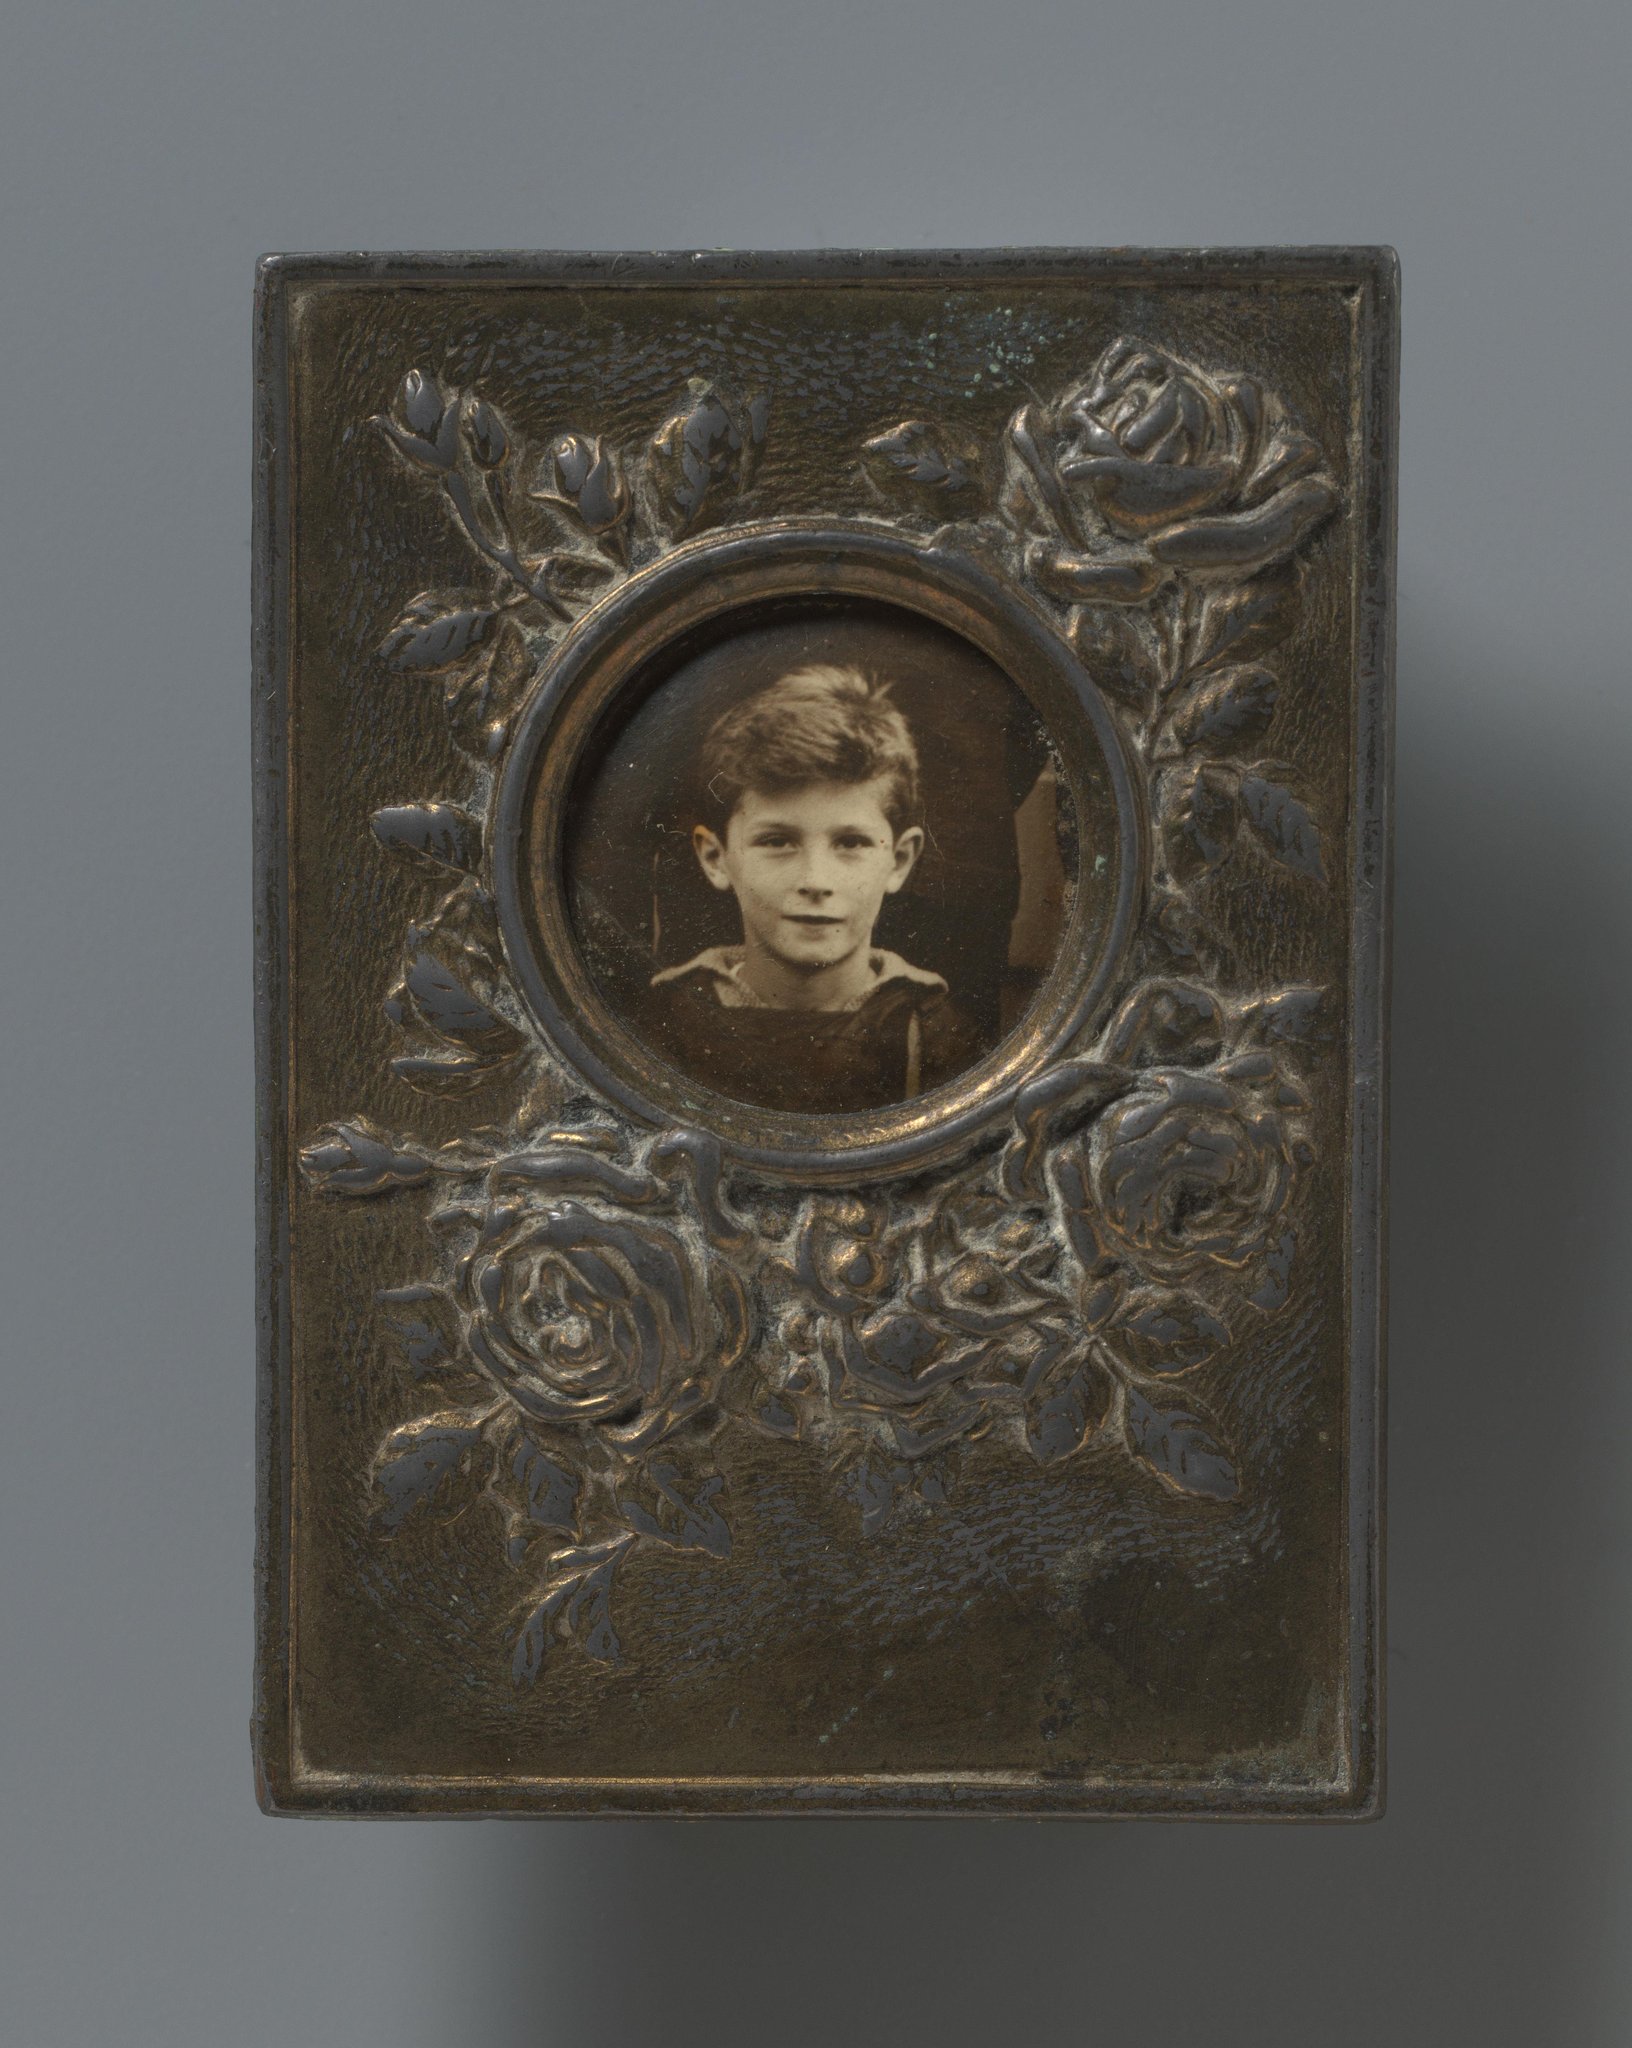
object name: photograph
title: Portret van een onbekende jongen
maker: Anonymous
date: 1900-1920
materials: paper, metal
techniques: gelatin silver print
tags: anonymous historical person portrayed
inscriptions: inscription: ‘GALB-EMAIL Bte SGDG/ FABRICATION FRANÇAISE/ No 67’